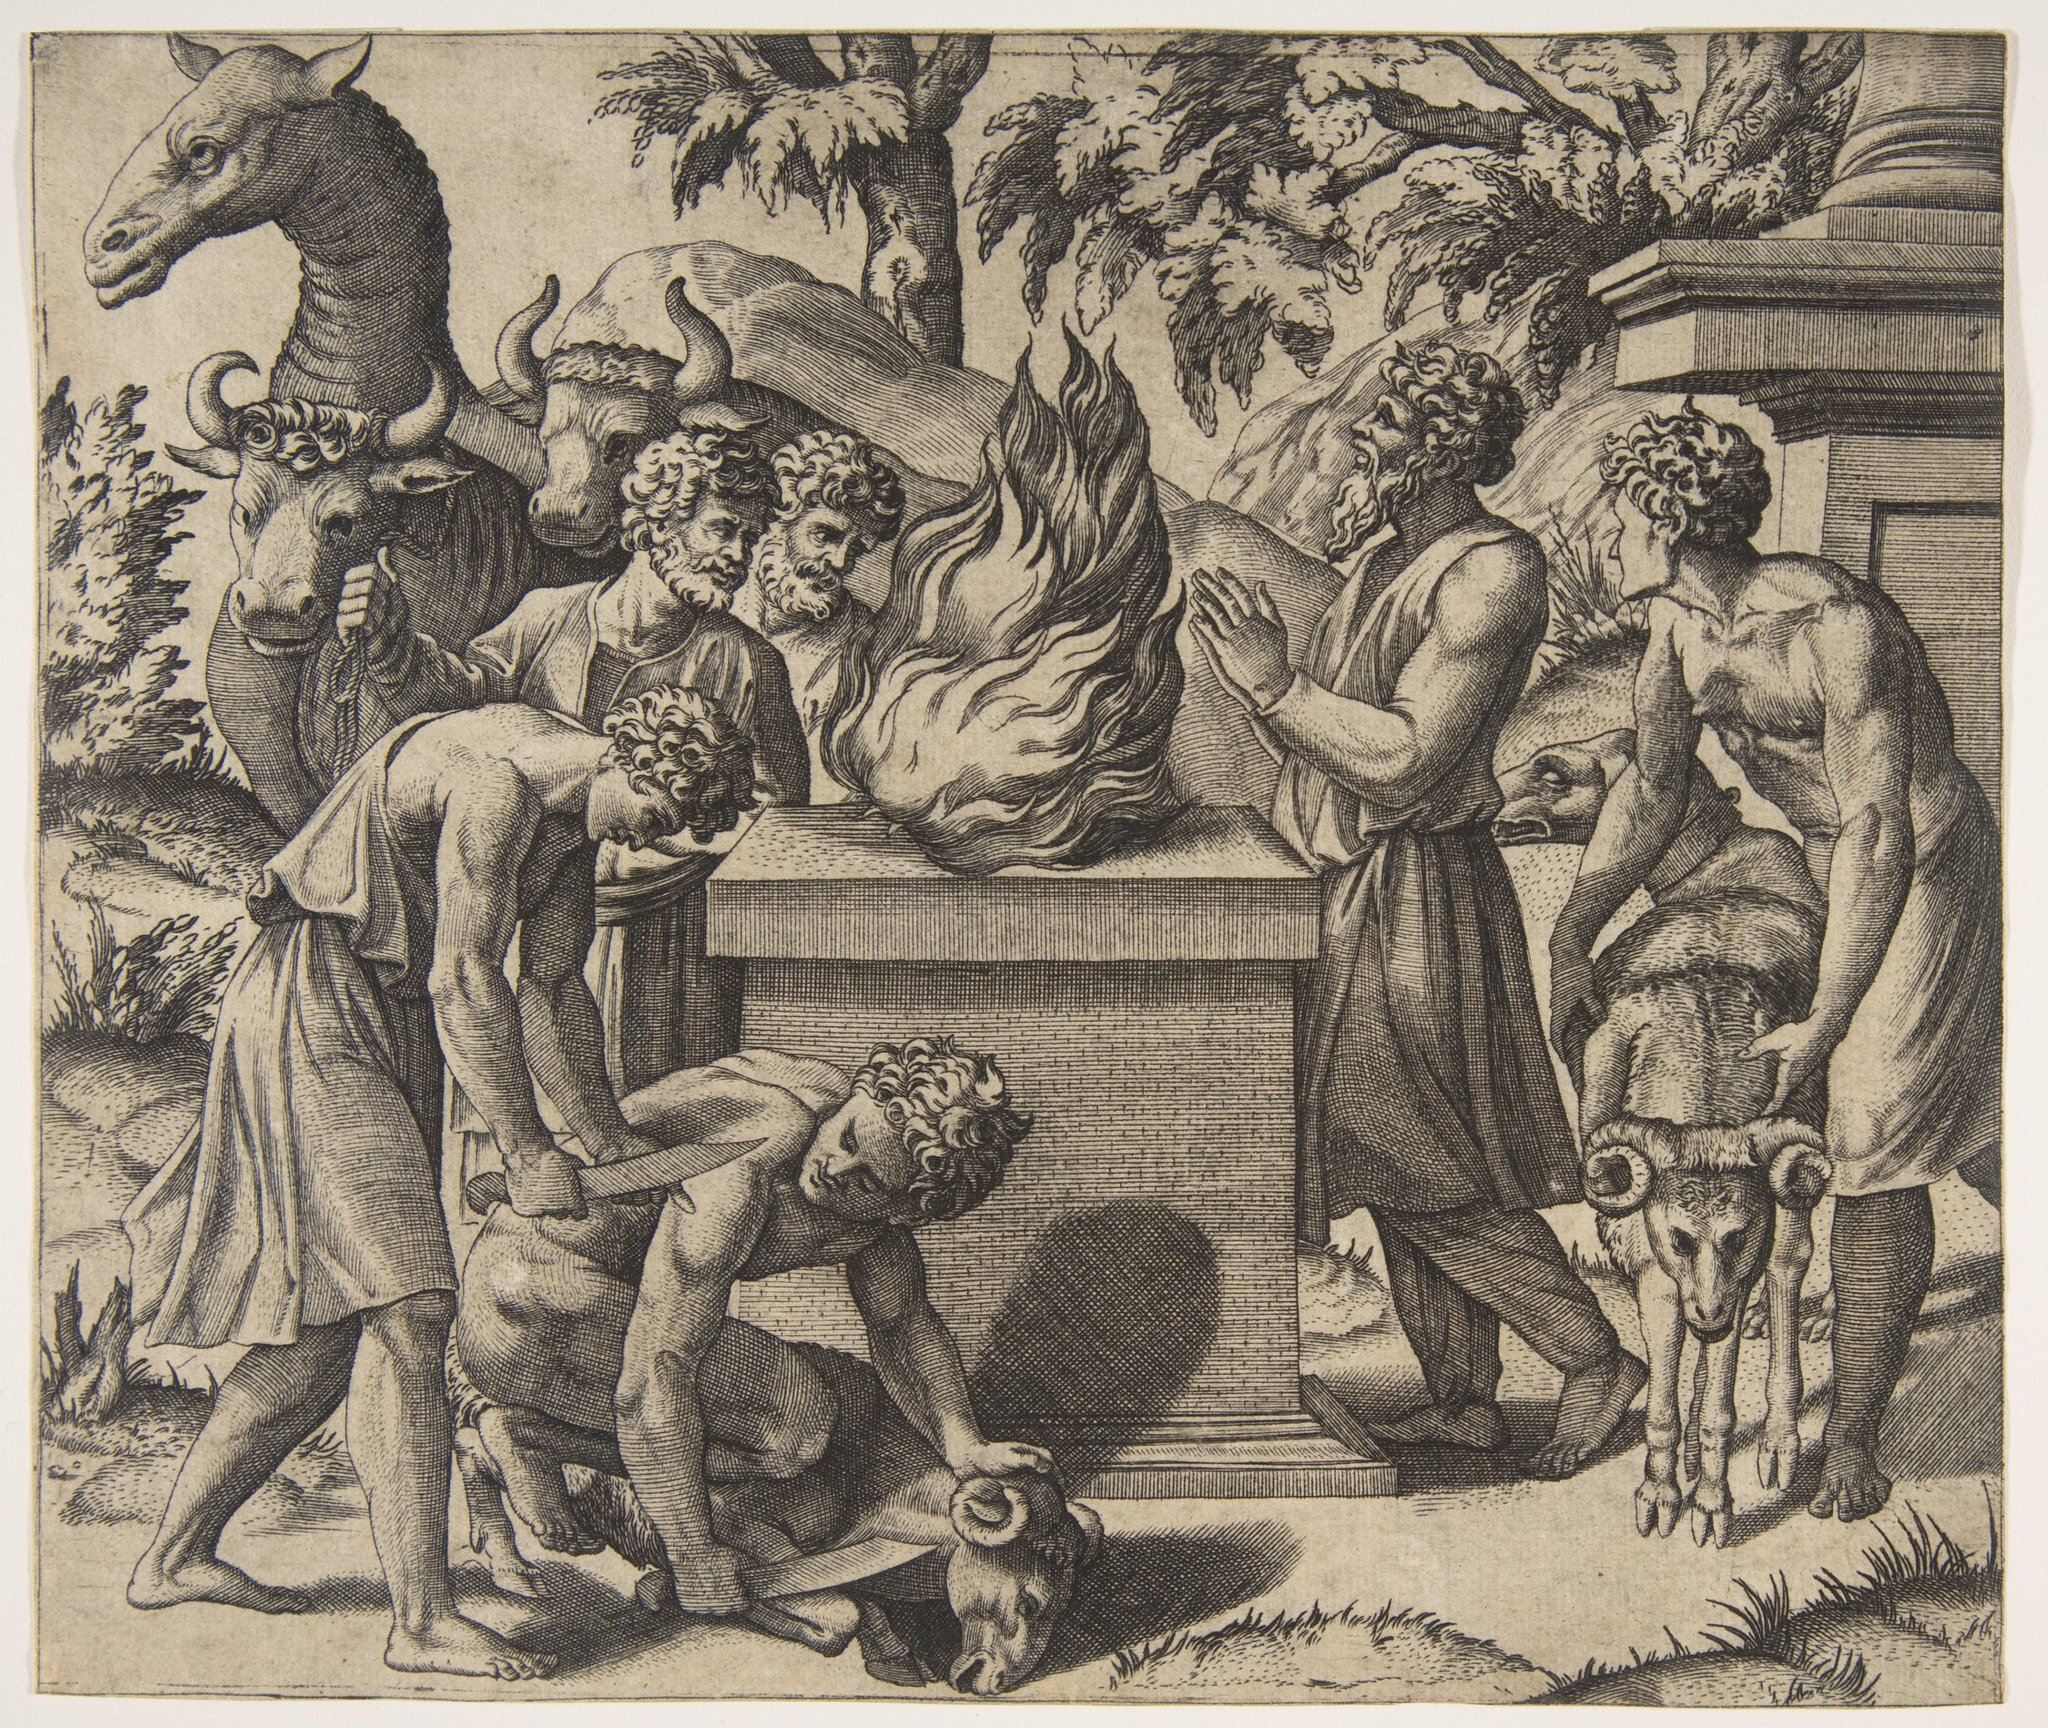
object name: print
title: Noah's Sacrifice; Noah at right with his hands clapsed in prayer before a fire upon an altar, two men sacrificing a ram on the ground and another bringing a second ram, two men leading two cows and a camel behind the fire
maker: marco dente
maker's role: artist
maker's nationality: italian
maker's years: 1515-1527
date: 1515-1527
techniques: engraving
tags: men,camels,cows,rams,fire